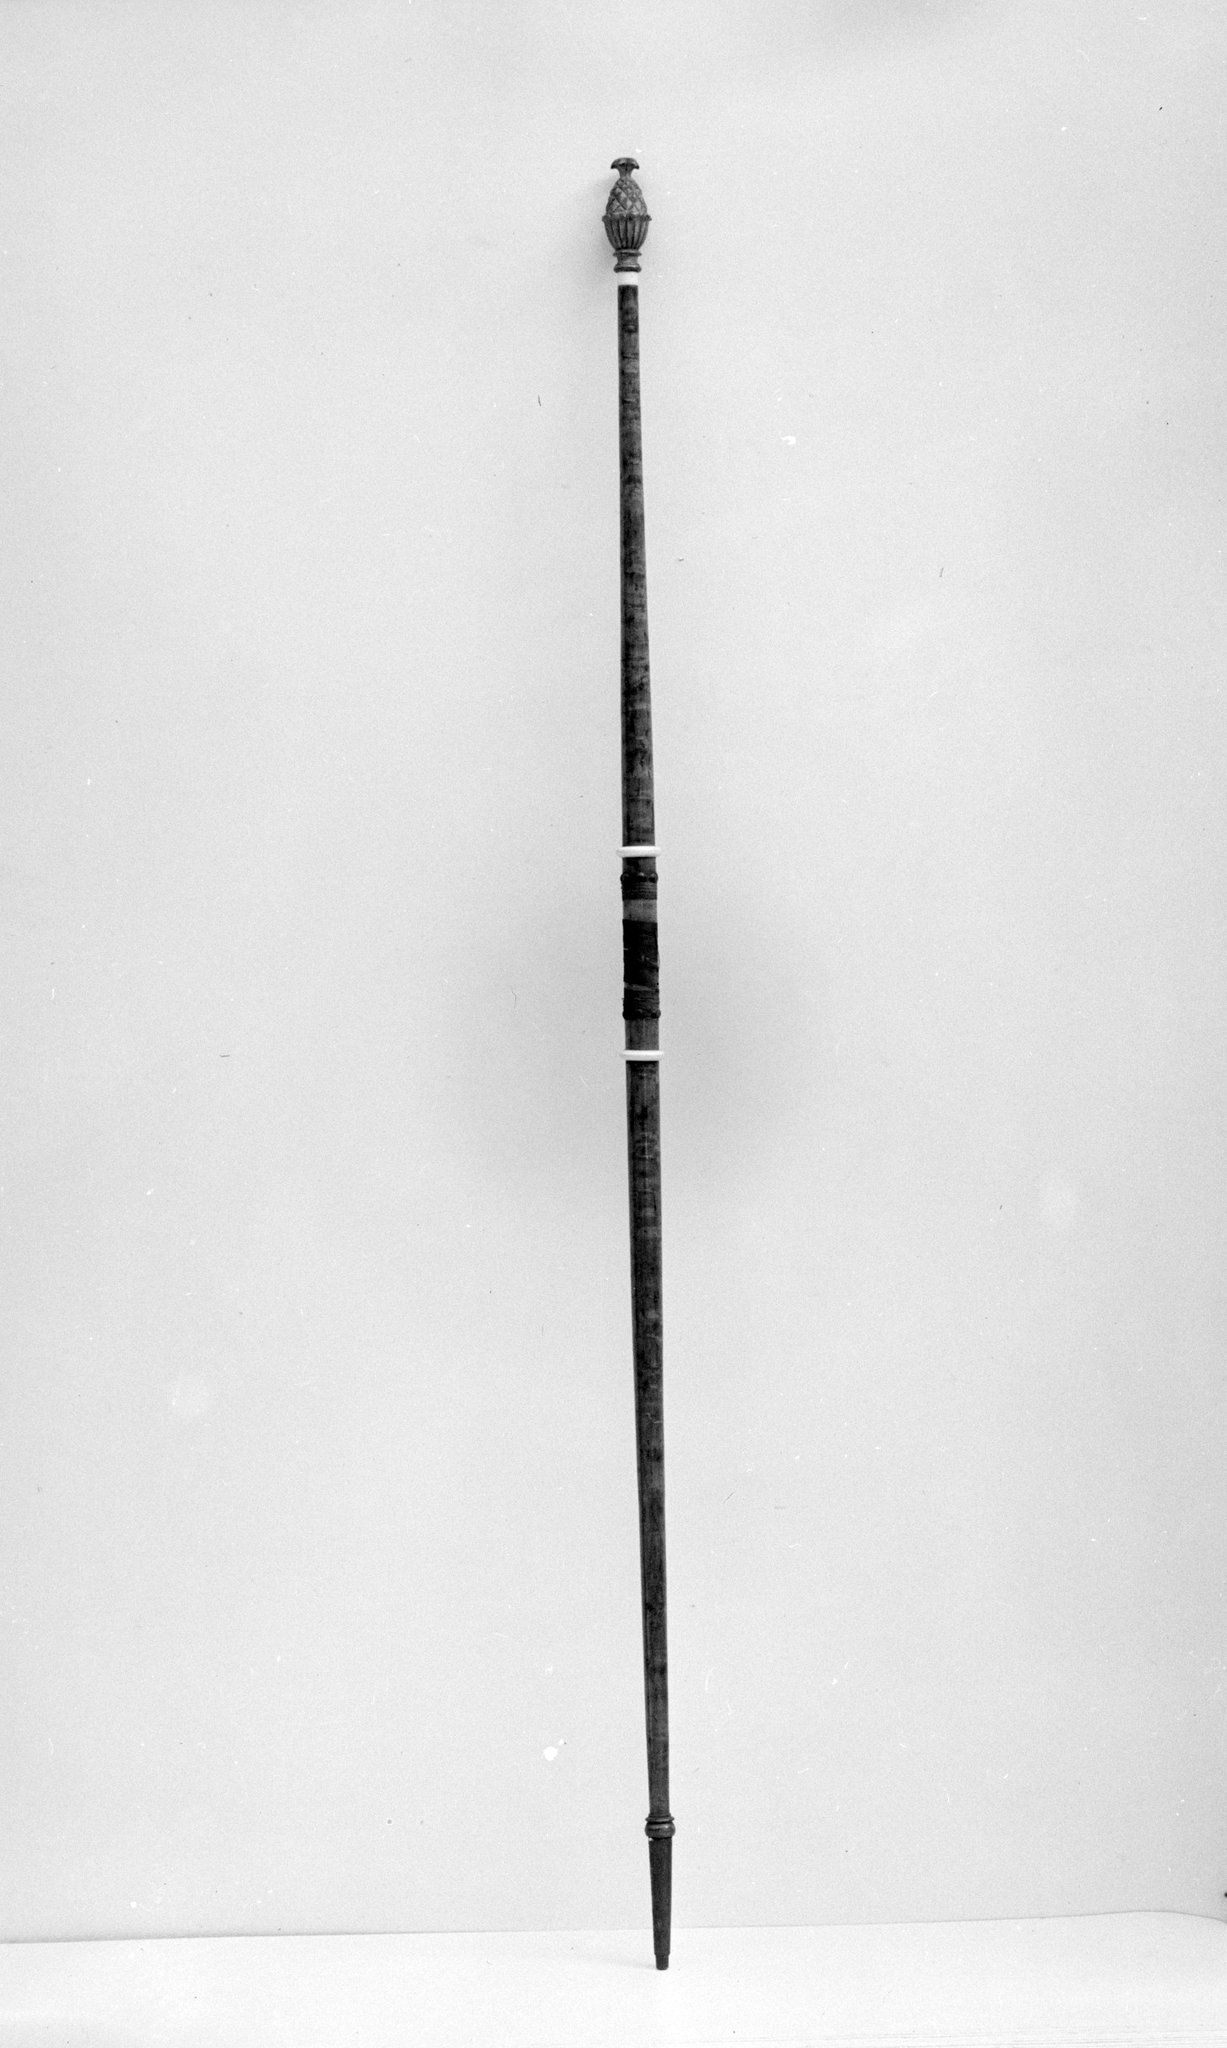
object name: staff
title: Official Staff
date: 1790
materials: brass, ivory, wood